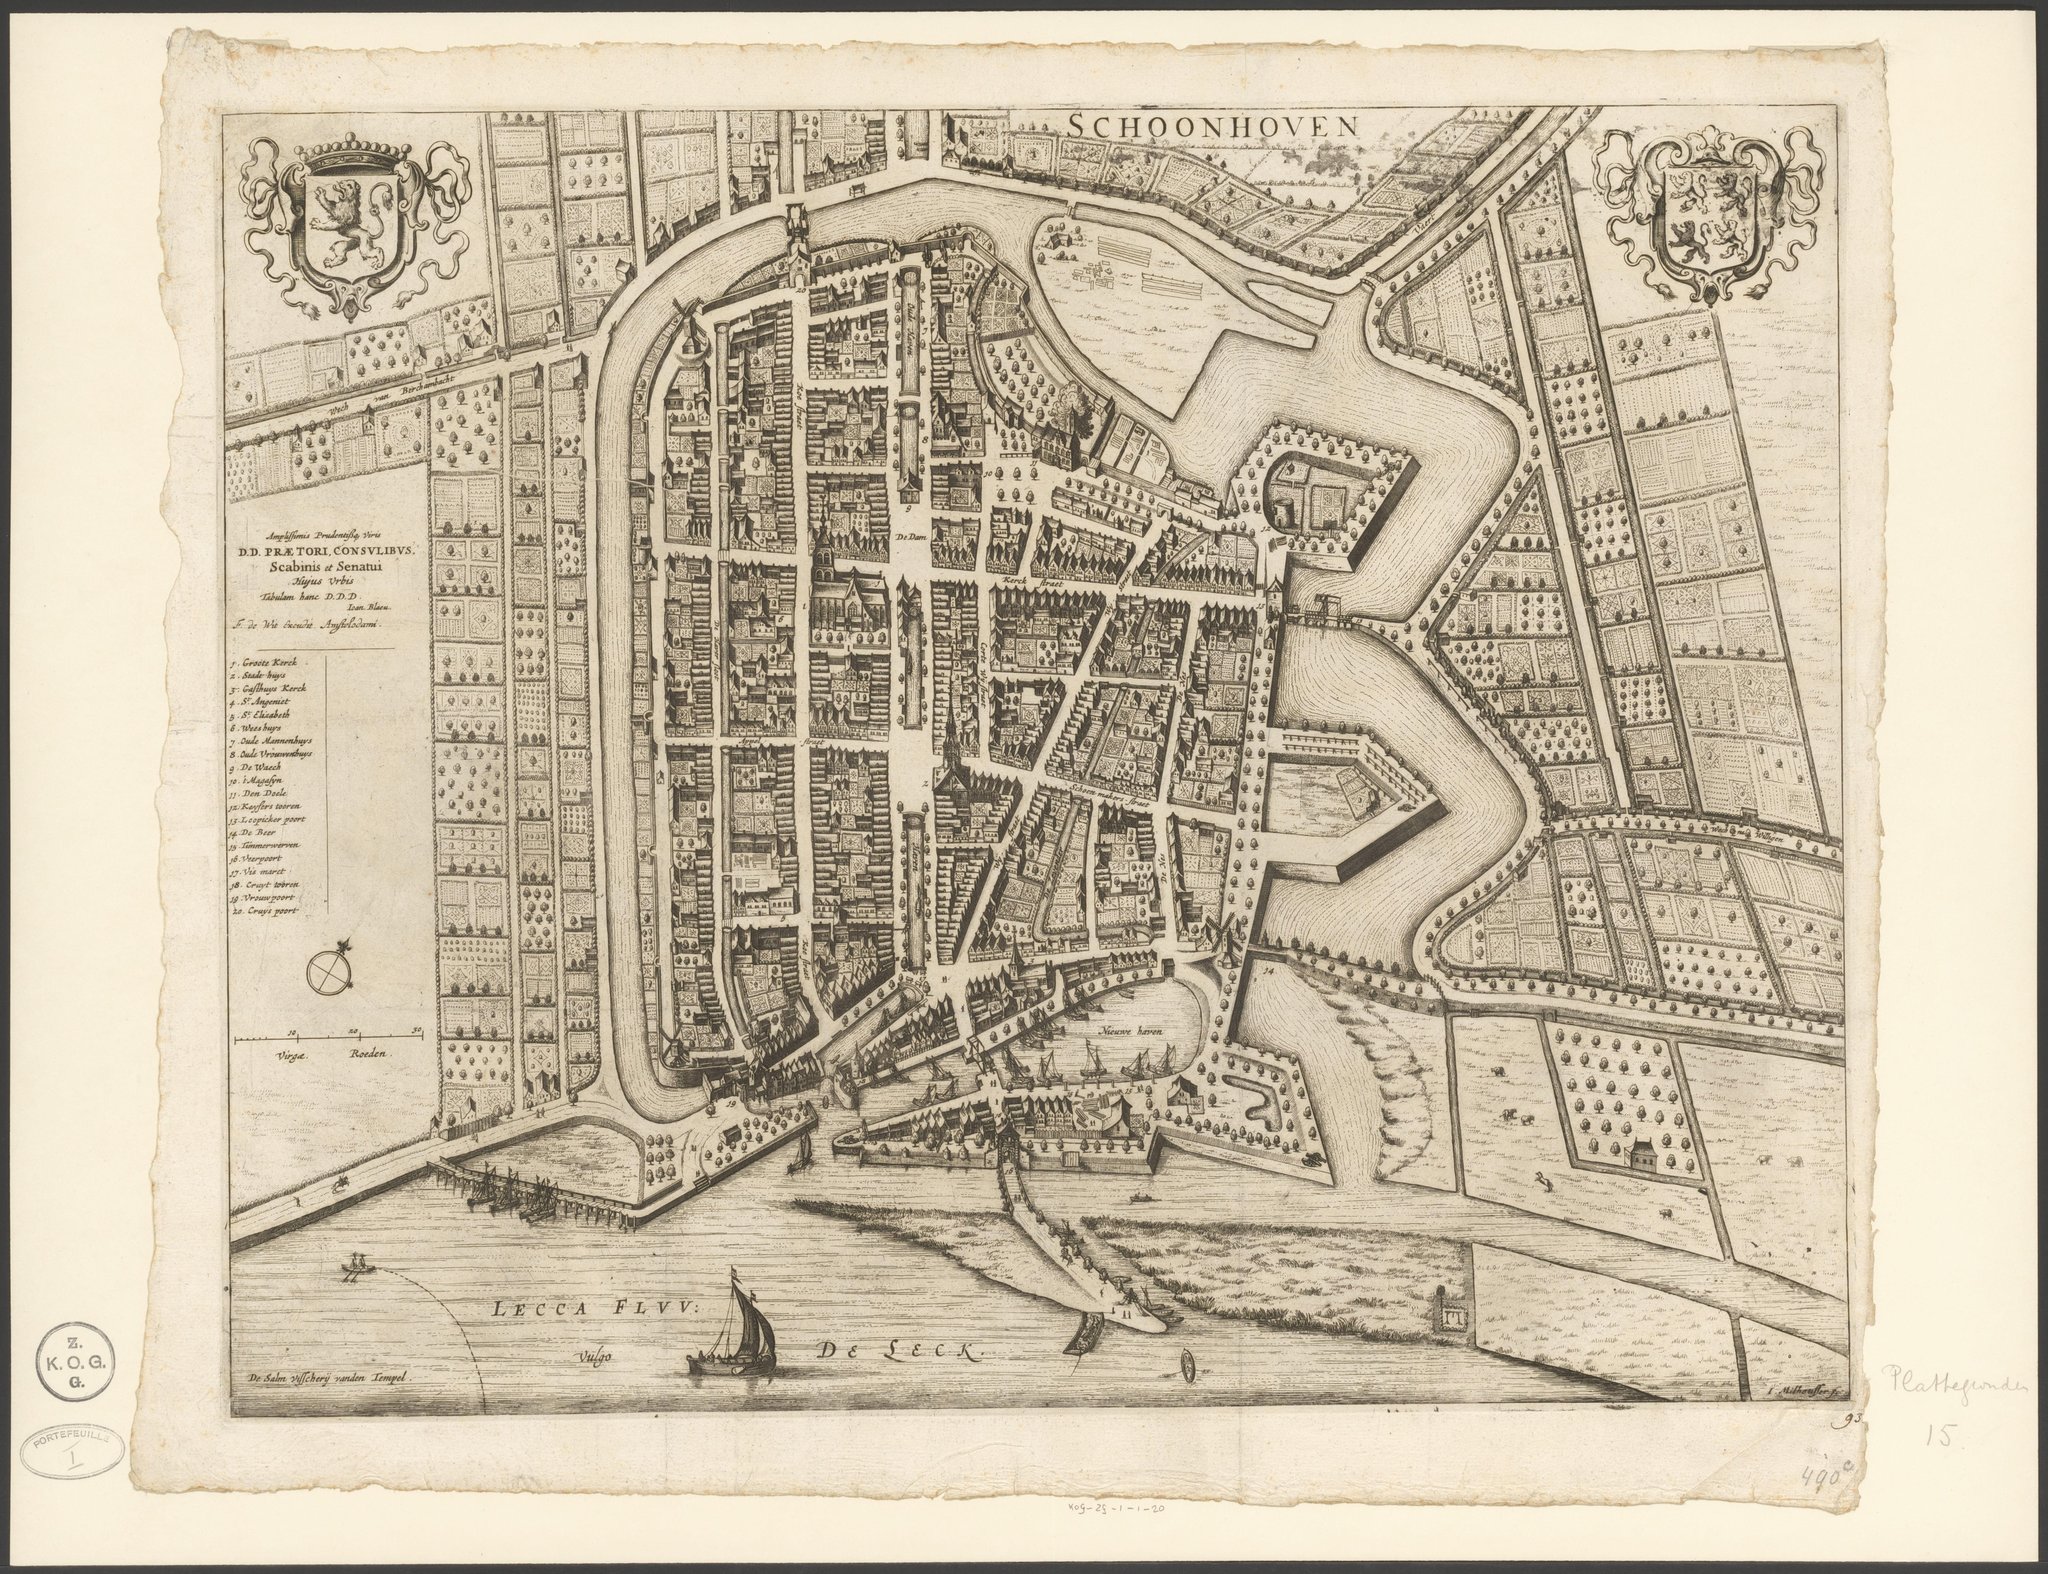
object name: area plan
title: Schoonhoven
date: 1649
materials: paper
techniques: engraving, etching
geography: amsterdam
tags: maps of cities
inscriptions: collector's mark, collector's mark: Lugt 1641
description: Deze staat van prent ook gebruikt in: Theatrum ichnographicum omnium urbium et praecipuorum oppidorum Belgicarum XVII Provinciarum (…). Amsterdam: Frederik de Wit, ca. 1700-1710. En in: Aa, Pieter van der. La galerie agreable du monde (...). 66 delen. Leiden: Pieter van der Aa, 1728, dl. 19.